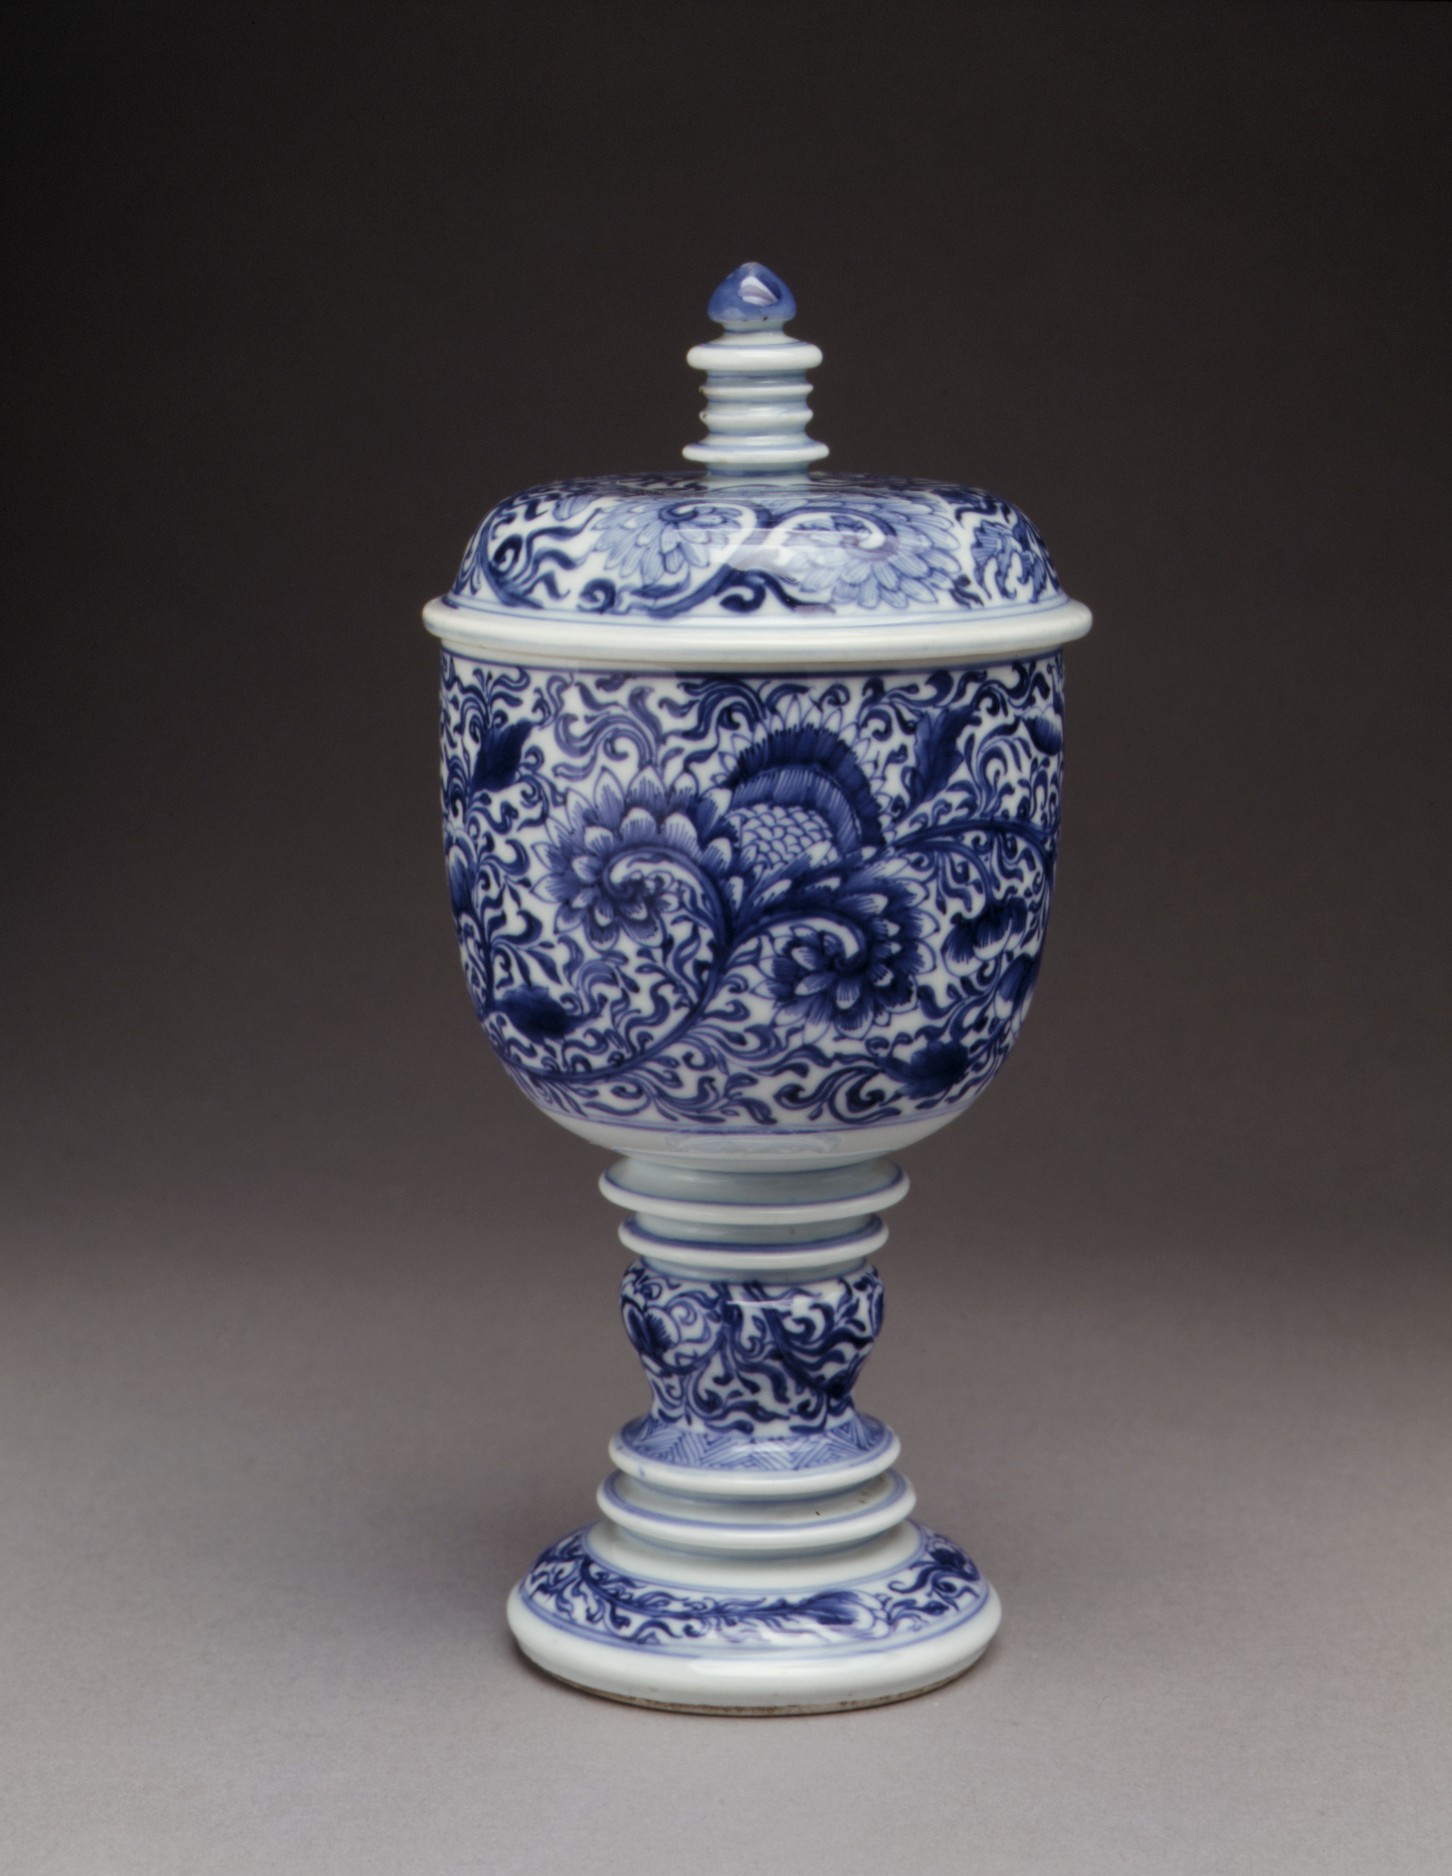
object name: standing cup with cover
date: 1690-1700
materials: hard paste porcelain